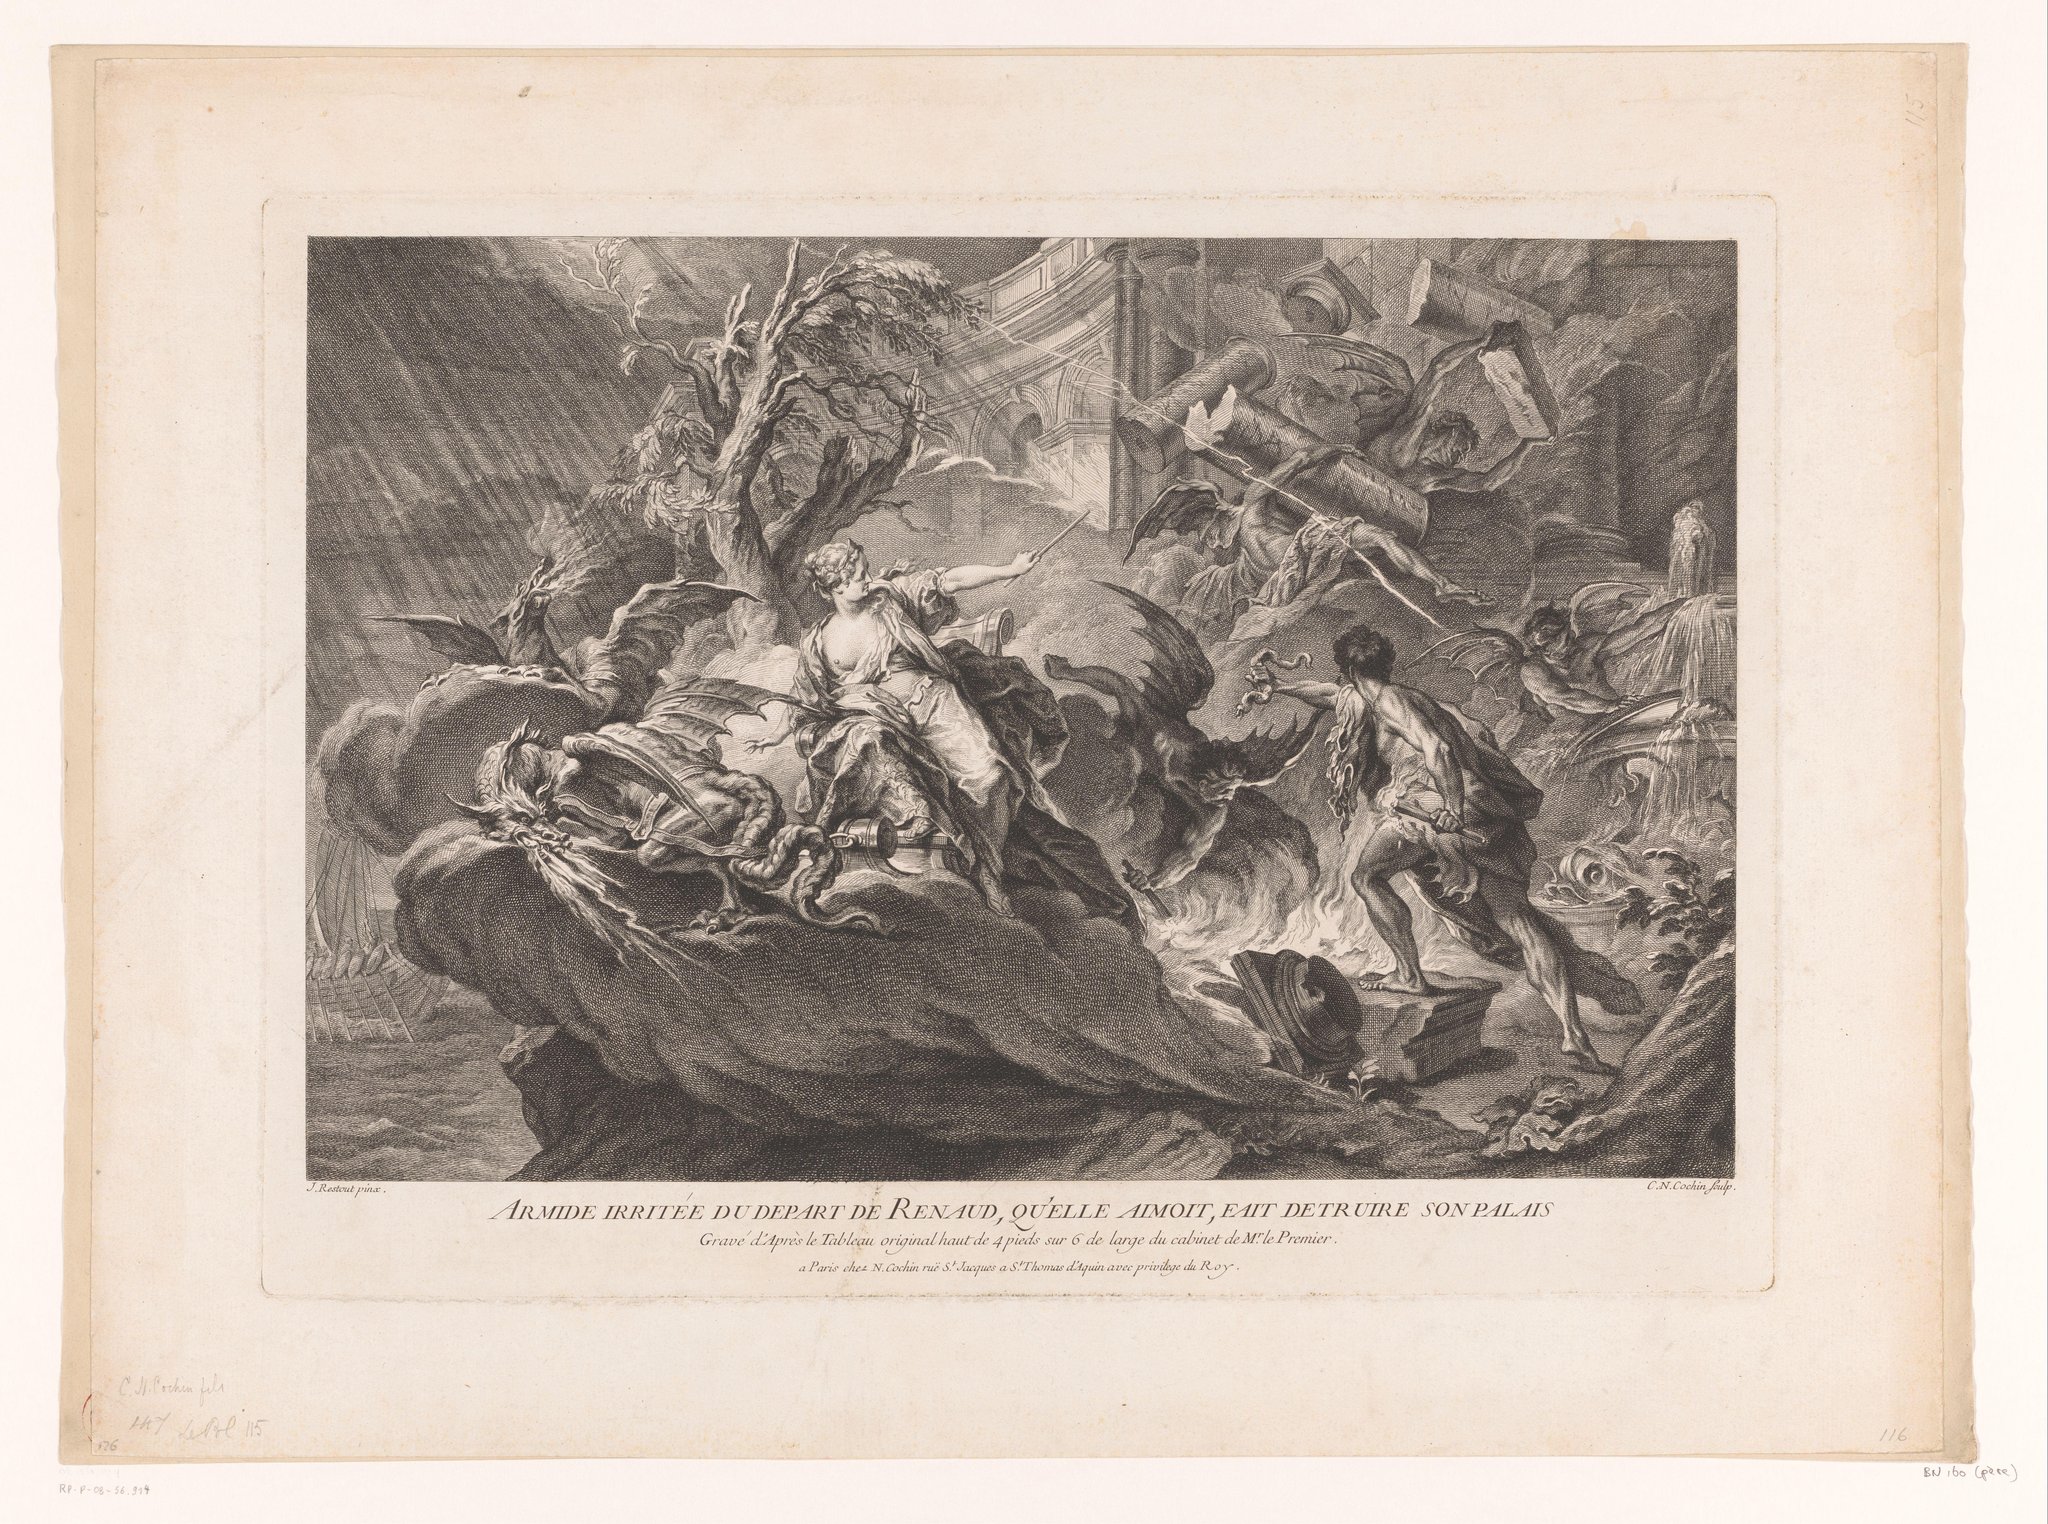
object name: print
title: Armide verwoest het paleis van Renaud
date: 1711-1736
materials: paper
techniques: engraving, etching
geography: france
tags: rinaldo, armida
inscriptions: collector's mark: Lugt 240